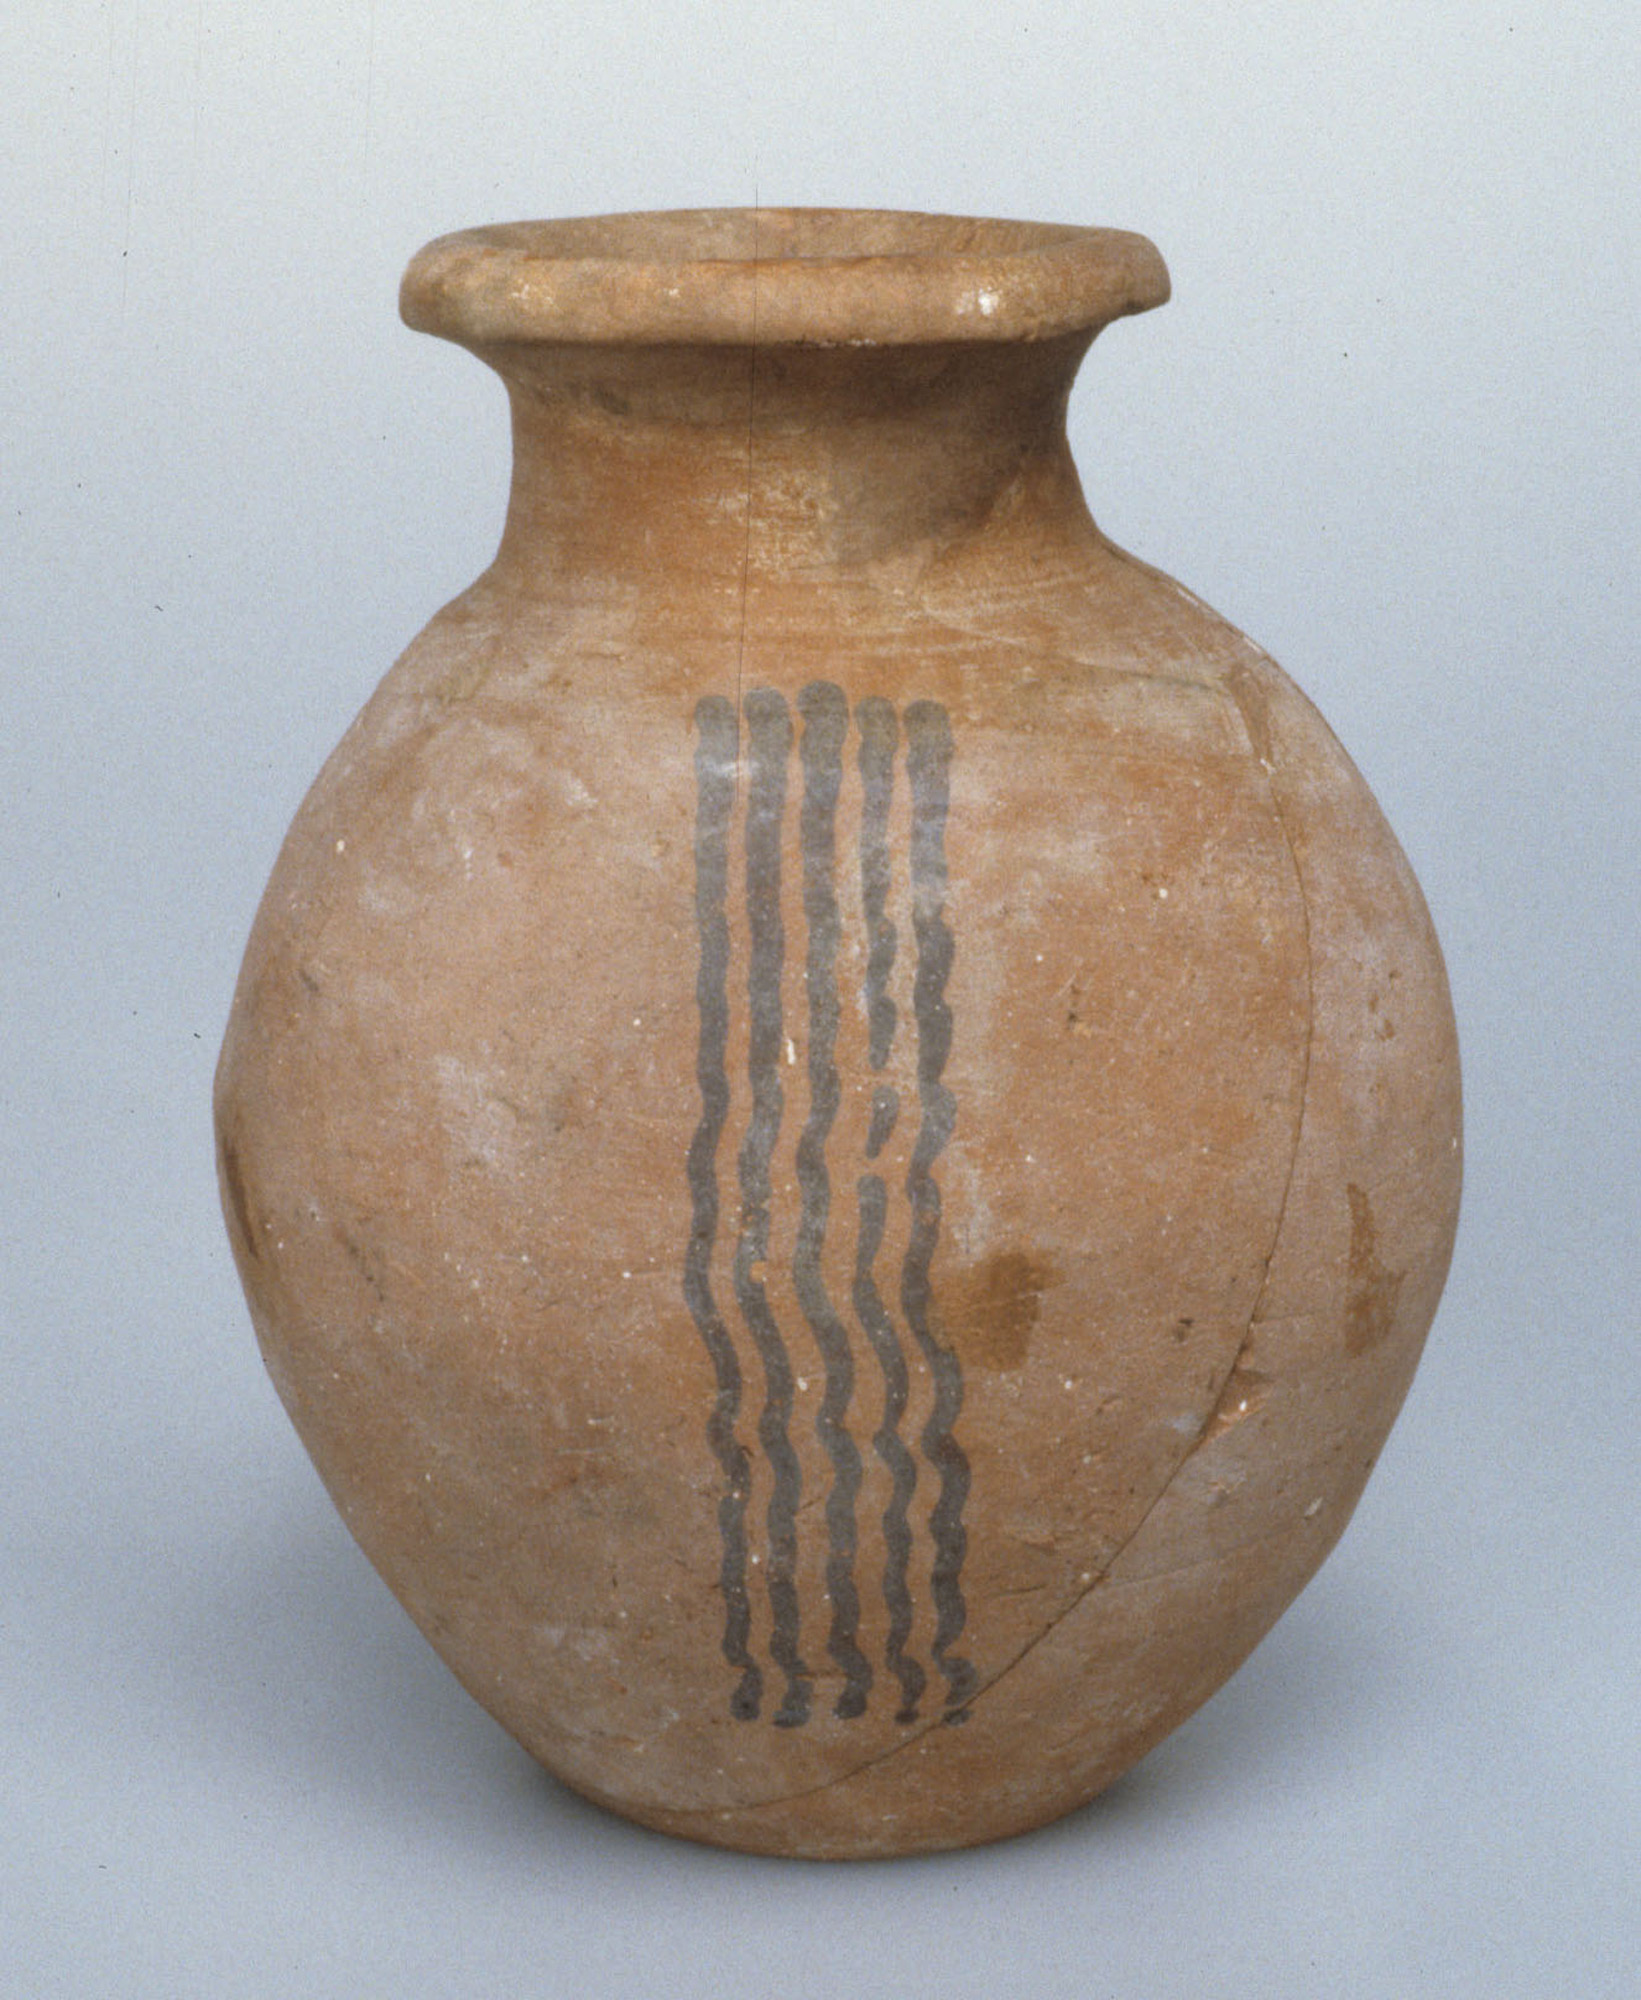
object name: jar, decorated ware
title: Late ware jar with wavy painted decoration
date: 3300-3100 BCE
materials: paint, pottery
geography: egypt